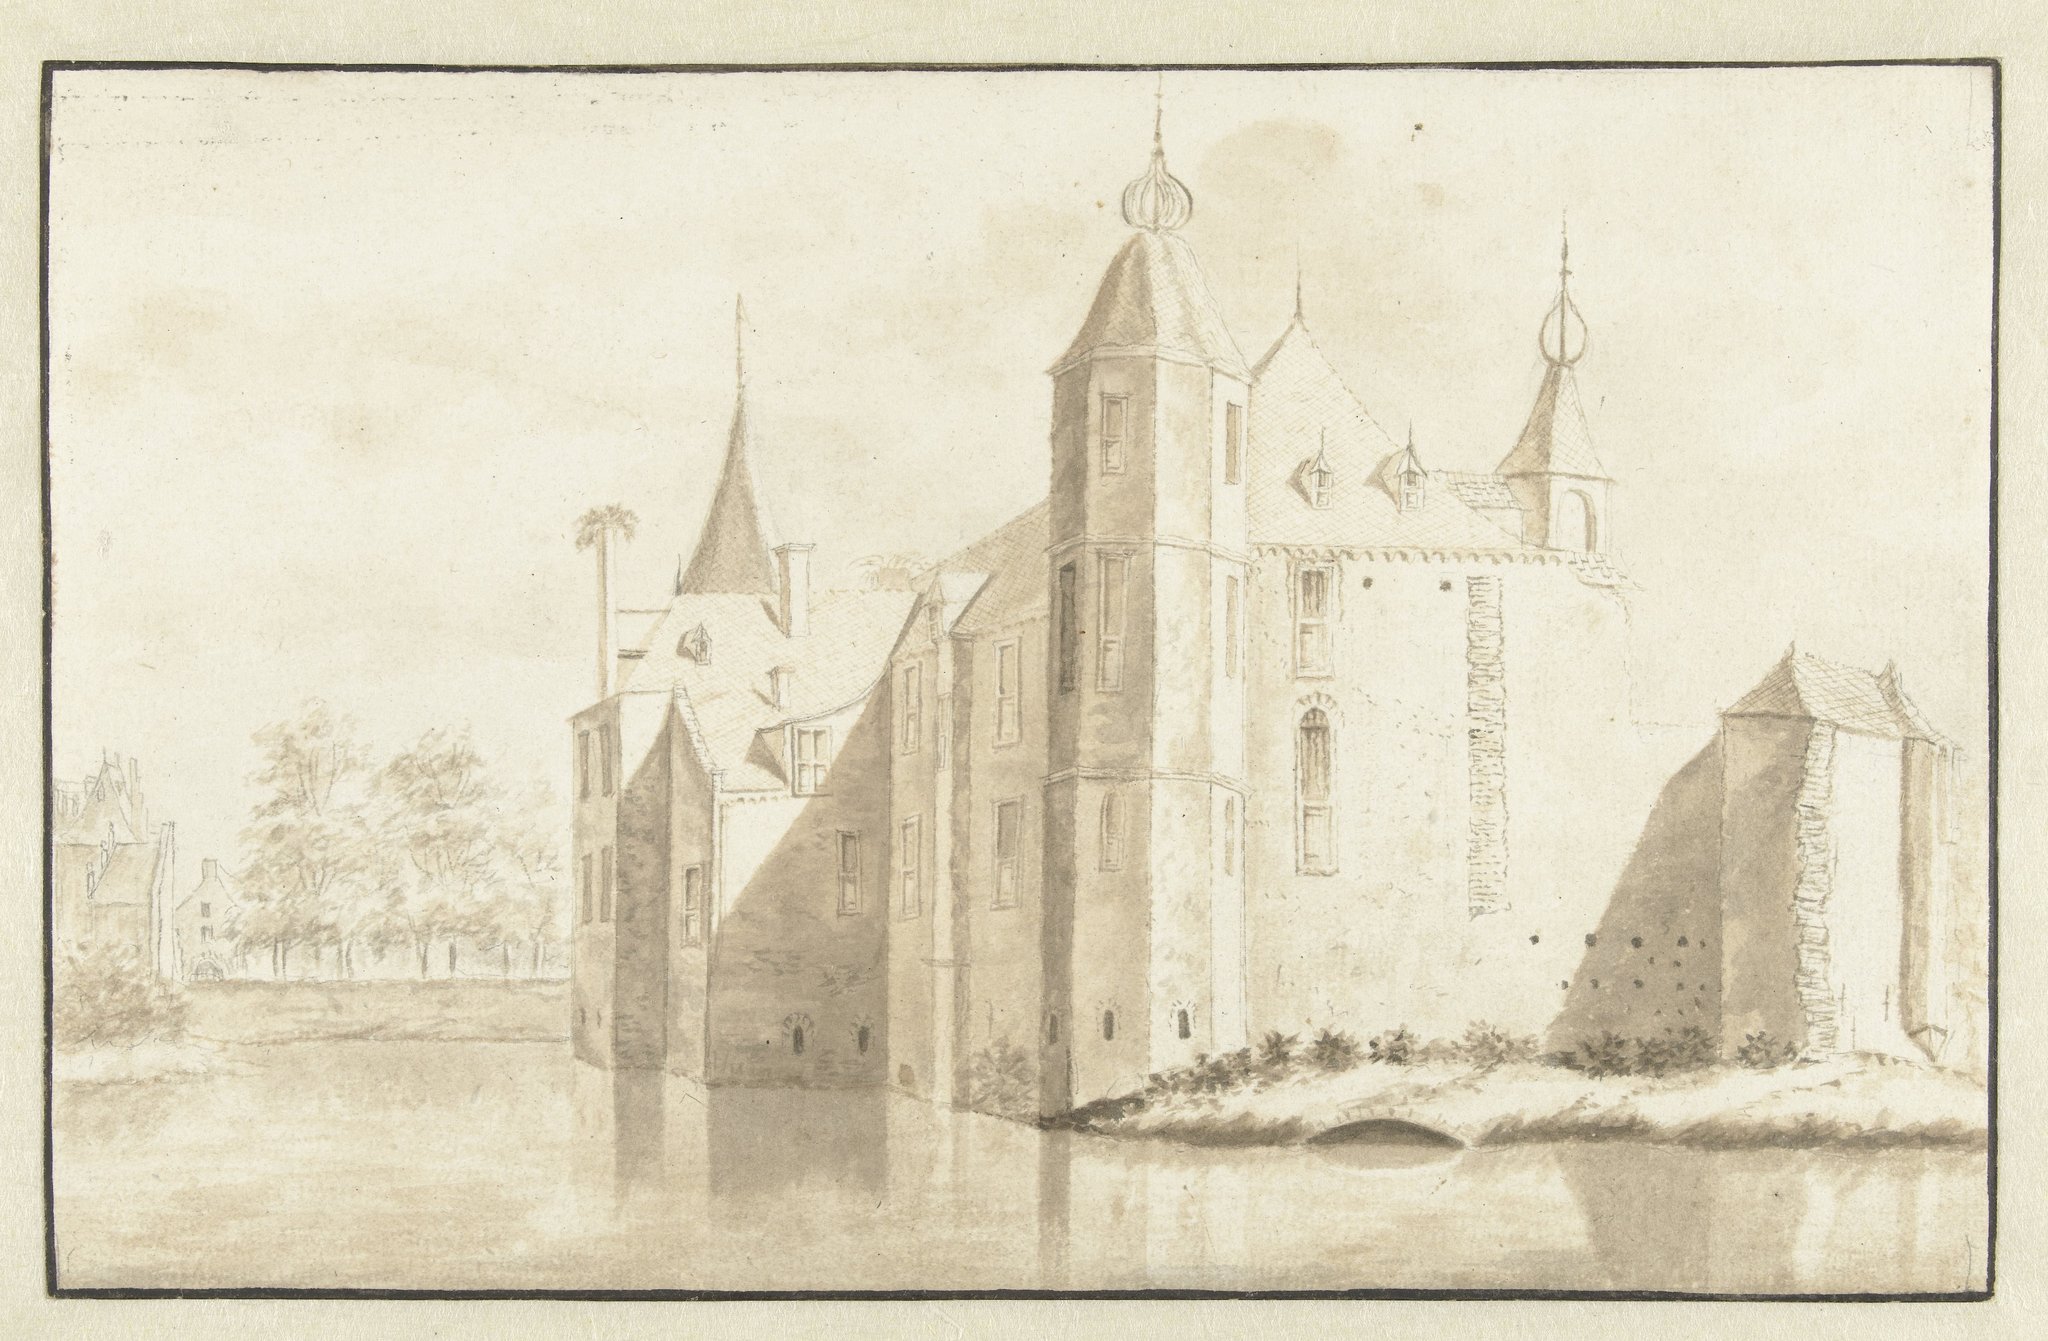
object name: drawing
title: Gezicht op het Huis Zuilen bij Maarssen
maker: abraham rademaker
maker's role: draughtsman, print maker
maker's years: 1676-1735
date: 1685-1735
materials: ink, paper, pencil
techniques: brush, pen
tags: castle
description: Kopie naar prent van Geertruydt Roghman.